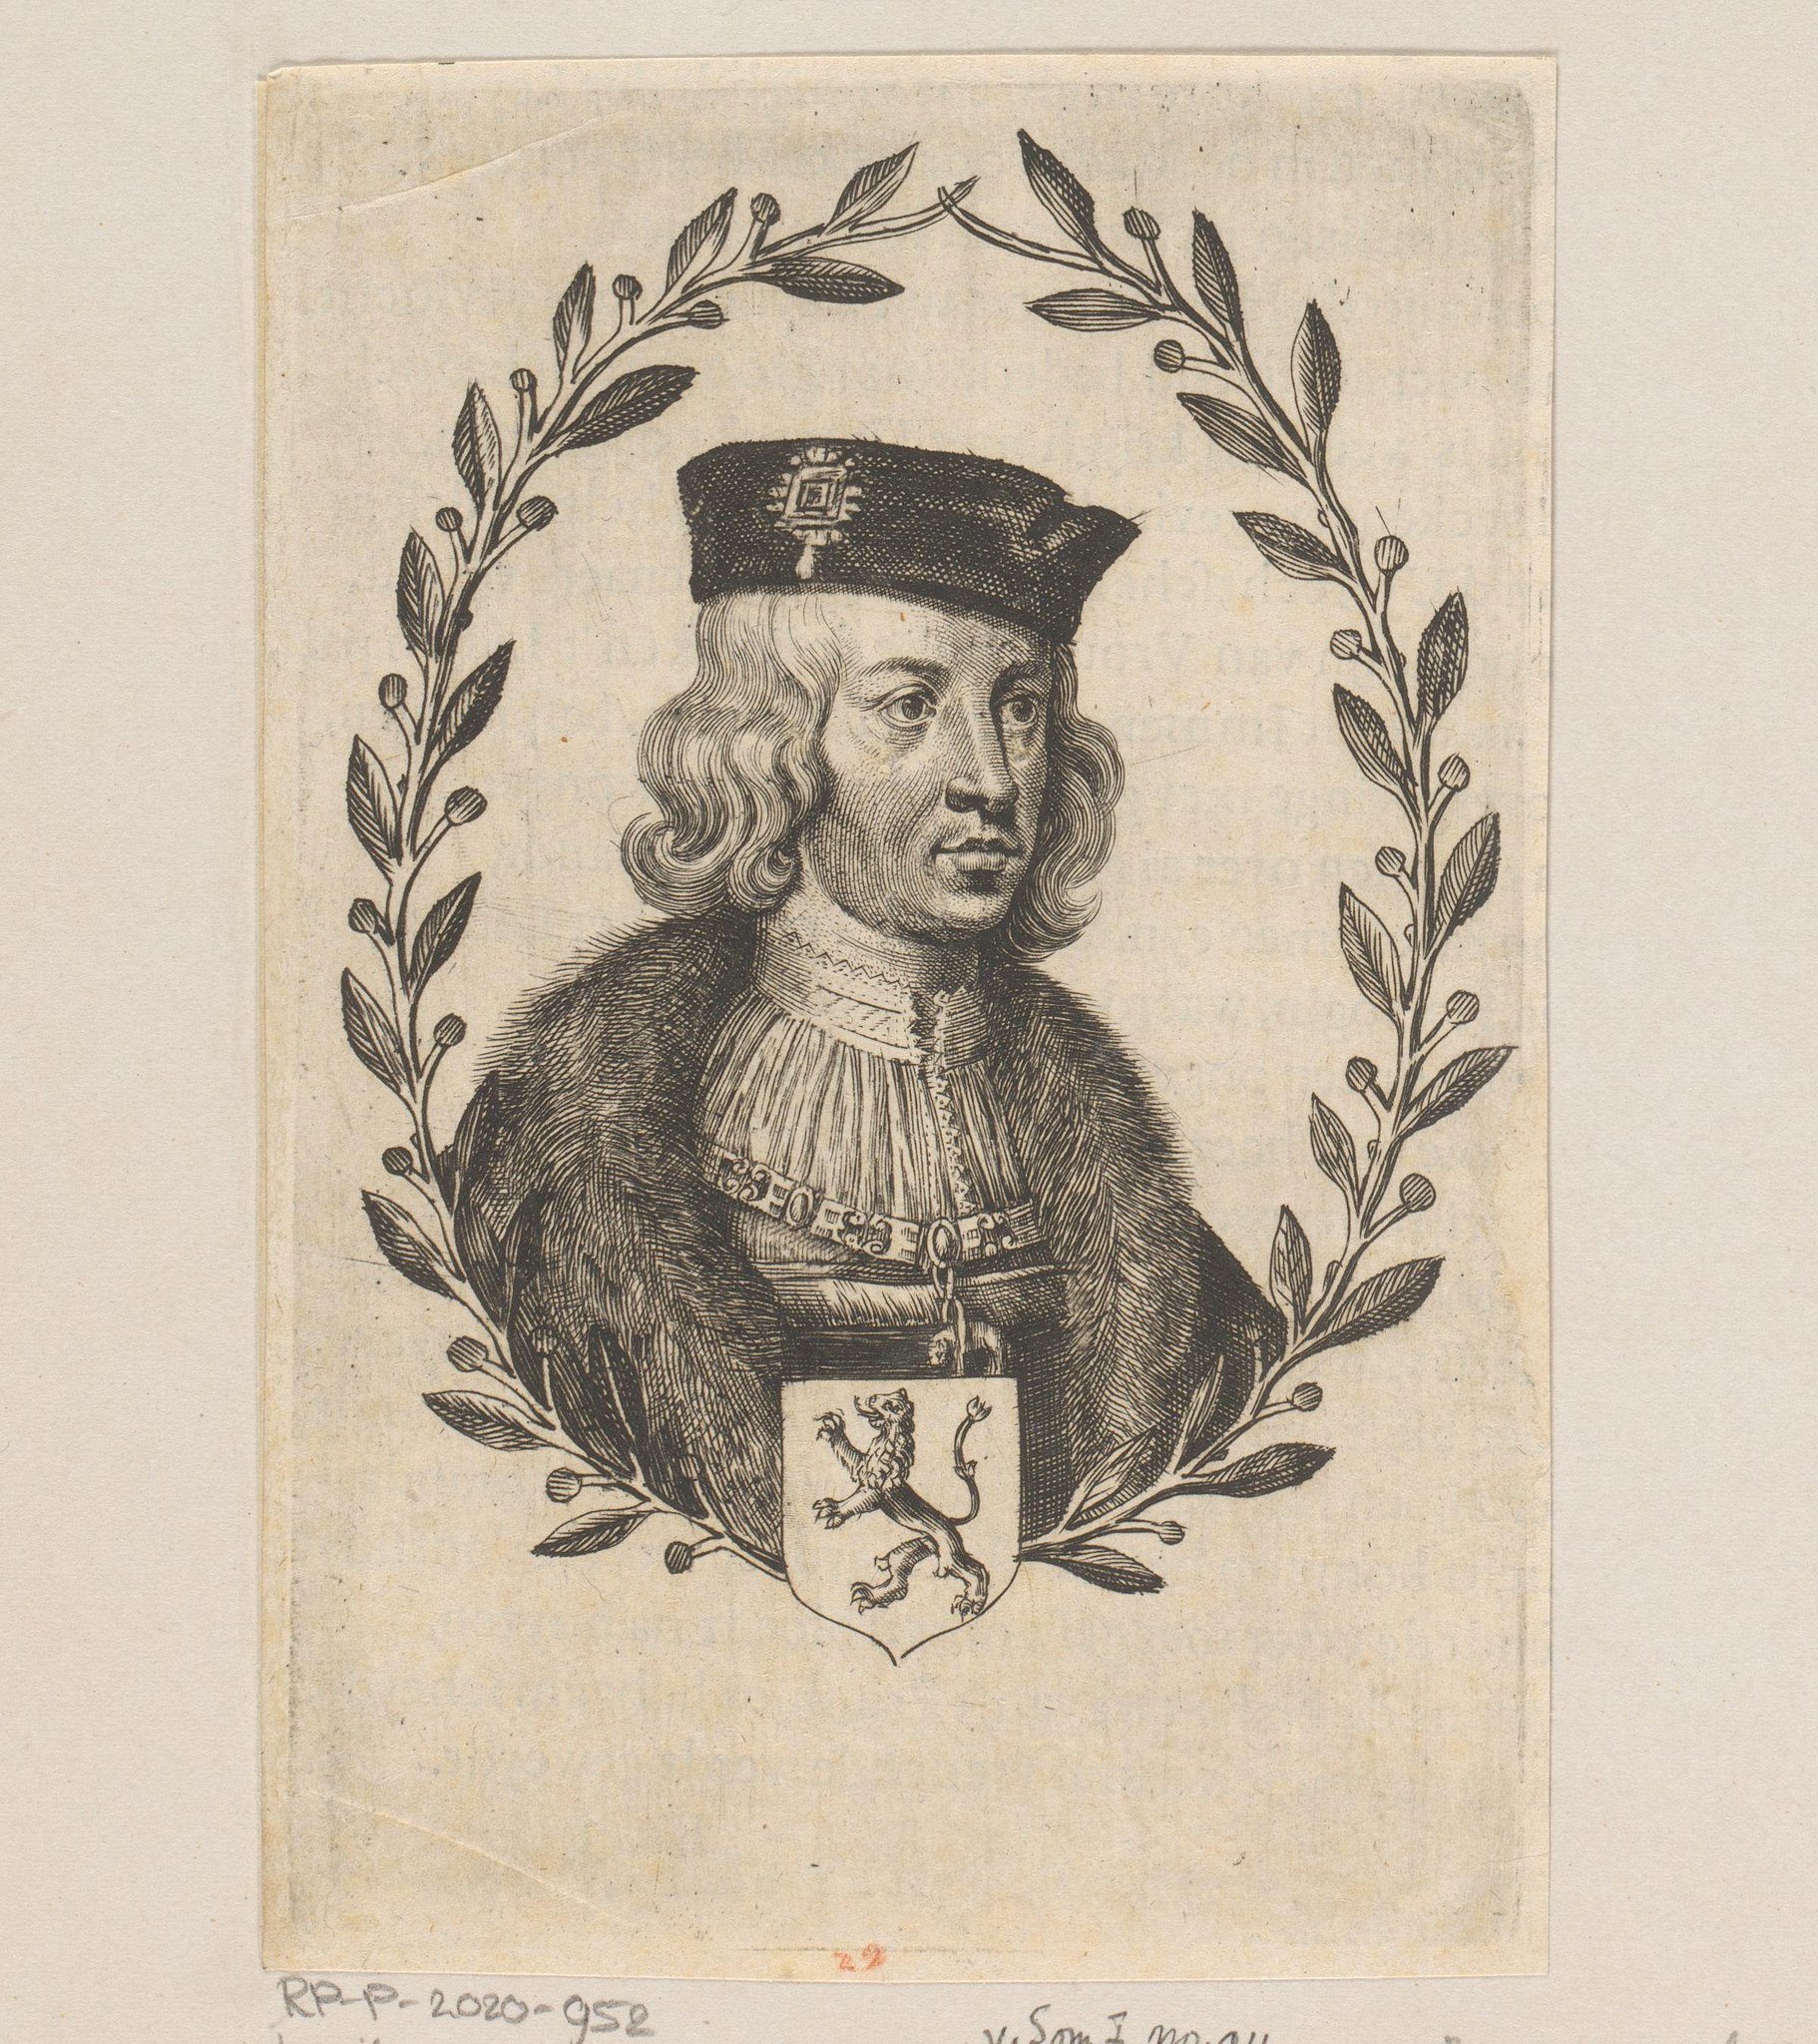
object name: print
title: Portret van Filips de Schone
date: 1645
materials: paper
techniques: engraving, letterpress printing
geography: amsterdam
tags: bruges, filips de schone (hertog van bourgondië), historical persons, ruler, sovereign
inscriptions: collector's mark: Lugt 240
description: Prent uit: Wachtendorp, Caspar. Oude Hollandsche geschiedenissen ofte, korte Hollandtsche rym-kronyck. 14 dln. Amsterdam: Johannes Pauli, 1645.